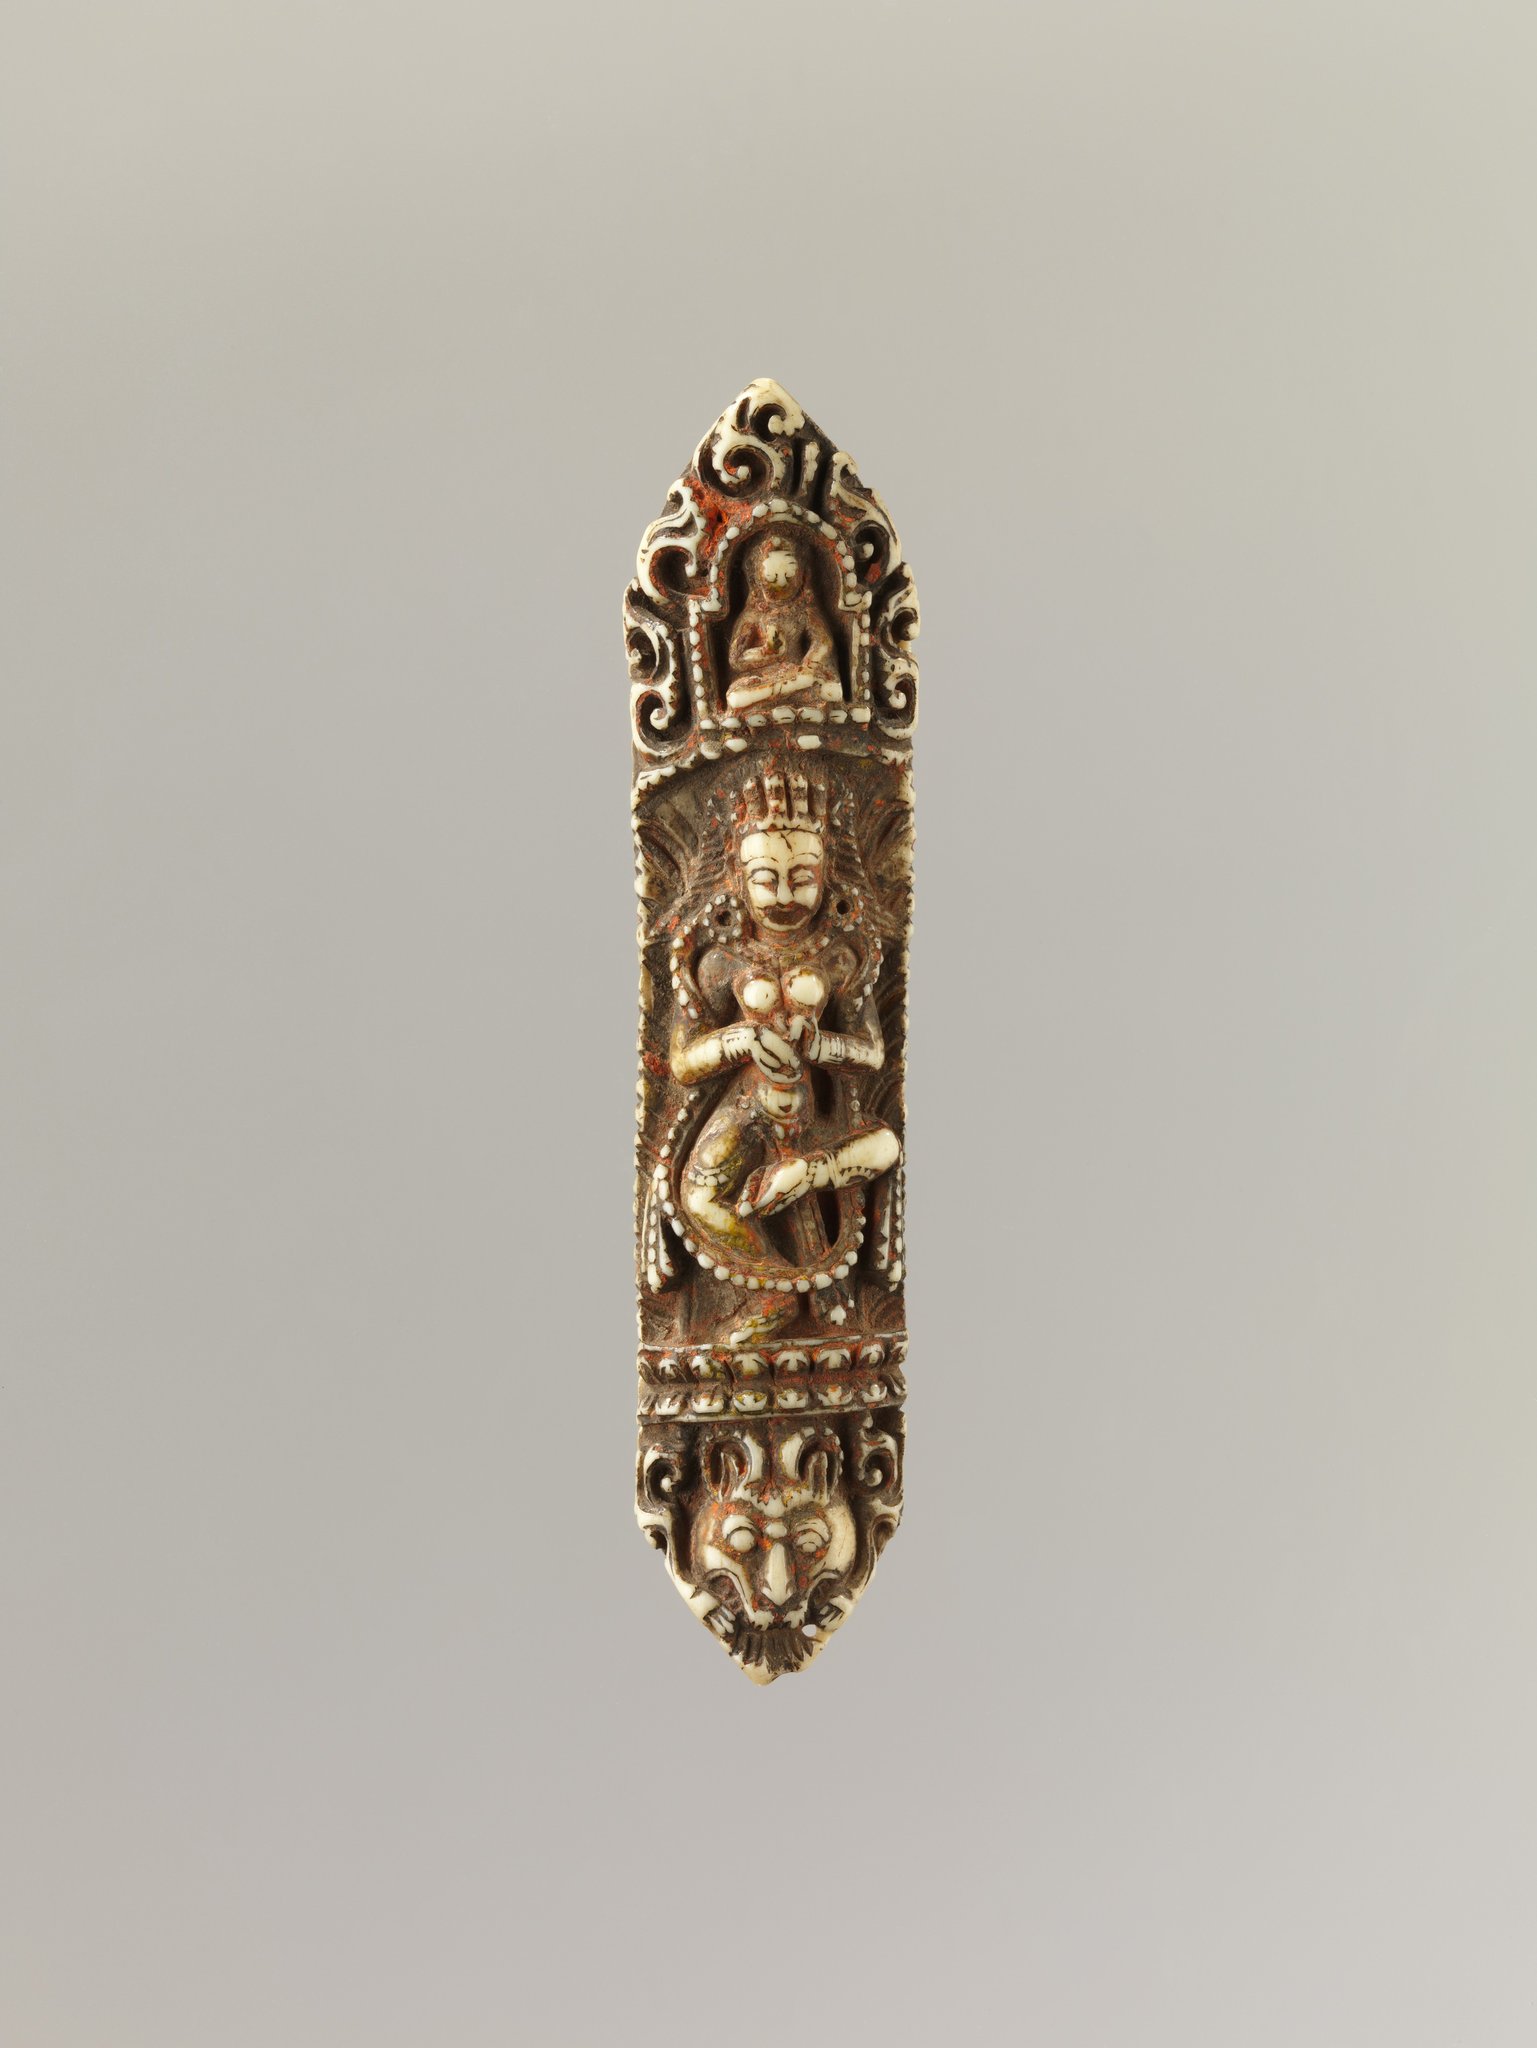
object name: plaque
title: Plaque from a Tantric Ritual Apron (Chakrasamvara and Vajravarahi at Center)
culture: nepali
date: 1501-1600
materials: bone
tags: women